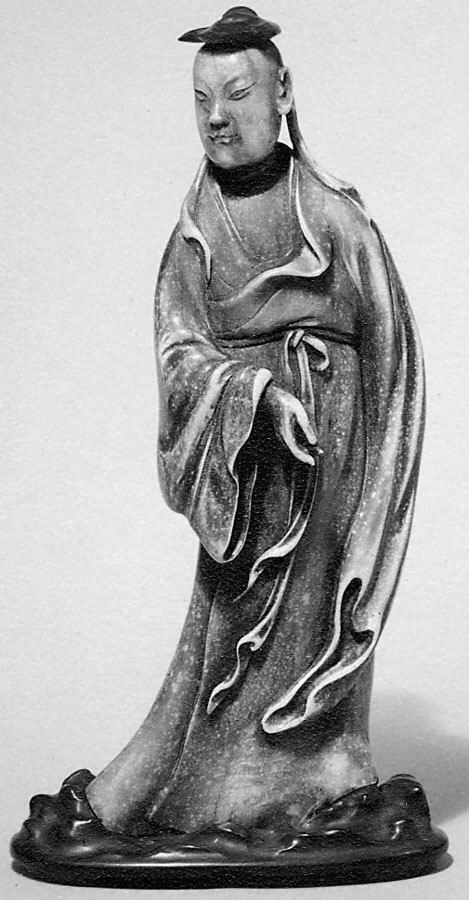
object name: statuette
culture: chinese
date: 1667-1700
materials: ivory, wood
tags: men